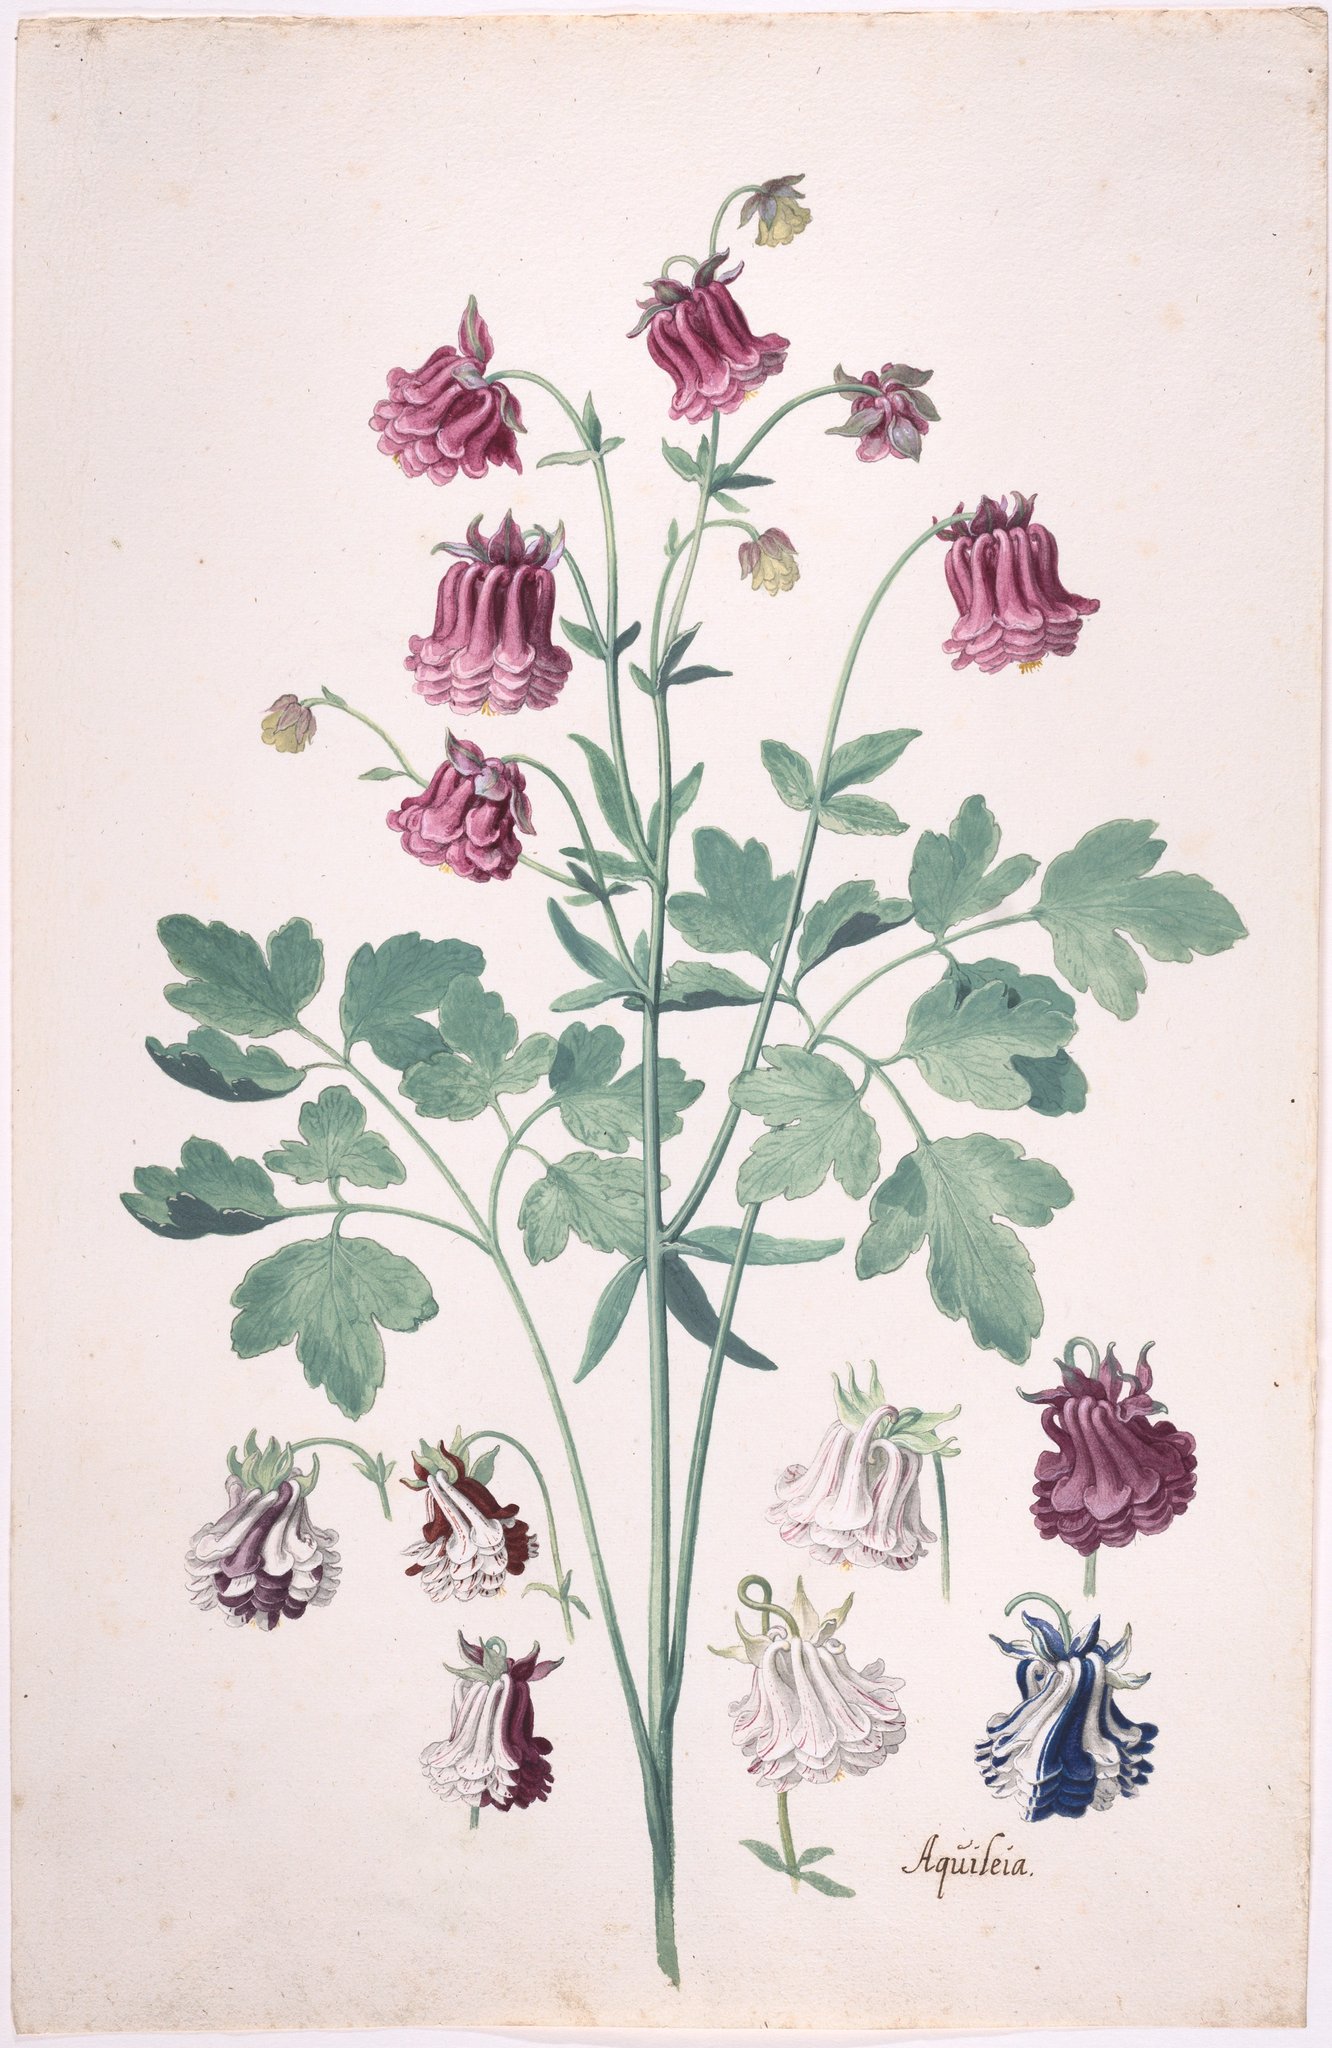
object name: drawing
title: A Columbine or Granny's Bonnet (Aquilegia), with Additional Studies of Flowers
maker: pieter holsteyn (ii)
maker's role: artist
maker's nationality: dutch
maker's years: 1614-1673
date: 1634-1700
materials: gouache, ink, watercolor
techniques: brush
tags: flowers